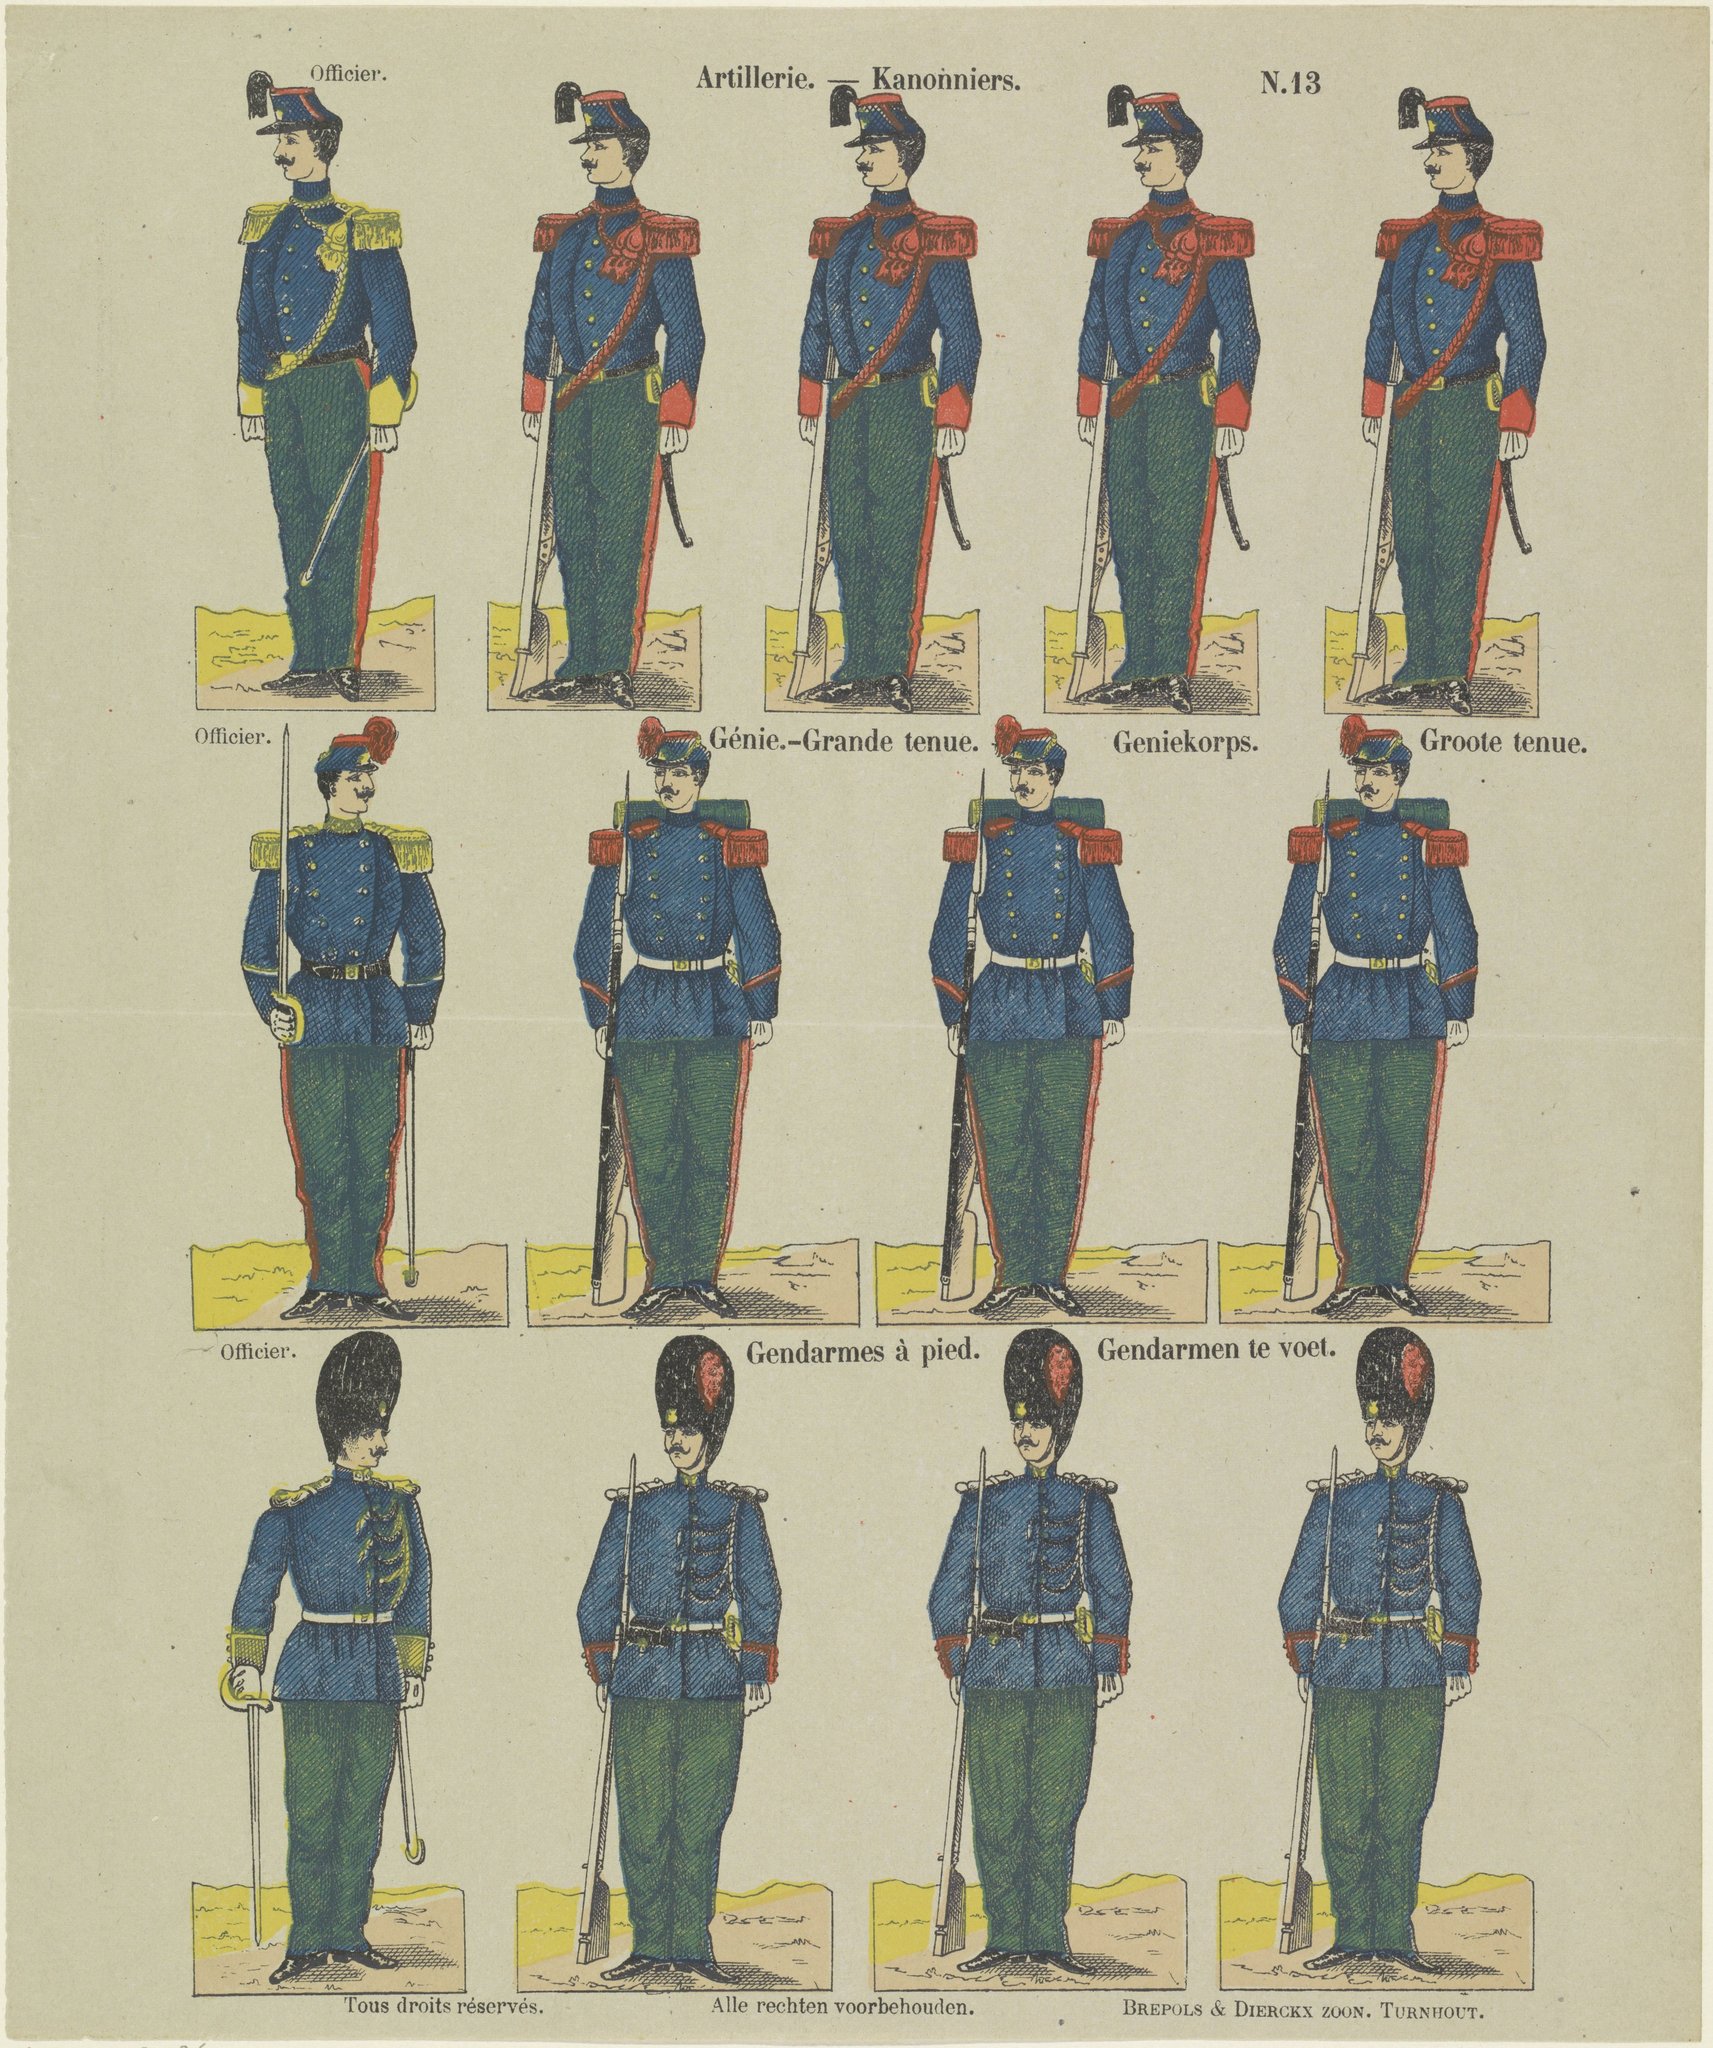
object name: print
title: Artillerie / Kanonniers / Génie.-Grande tenue / Geniekorps groote tenue / Gendarmes à pied / Gendarmen te voet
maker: Anonymous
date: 1833-1911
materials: paper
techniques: lithograph, letterpress printing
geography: turnhout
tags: the soldier; the soldier's life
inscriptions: collector's mark: Lugt 2760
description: Blad met 3 horizontale rijen met in totaal 13 voorstellingen van officieren en militairen met geweren. Genummerd rechtsboven: N. 13.